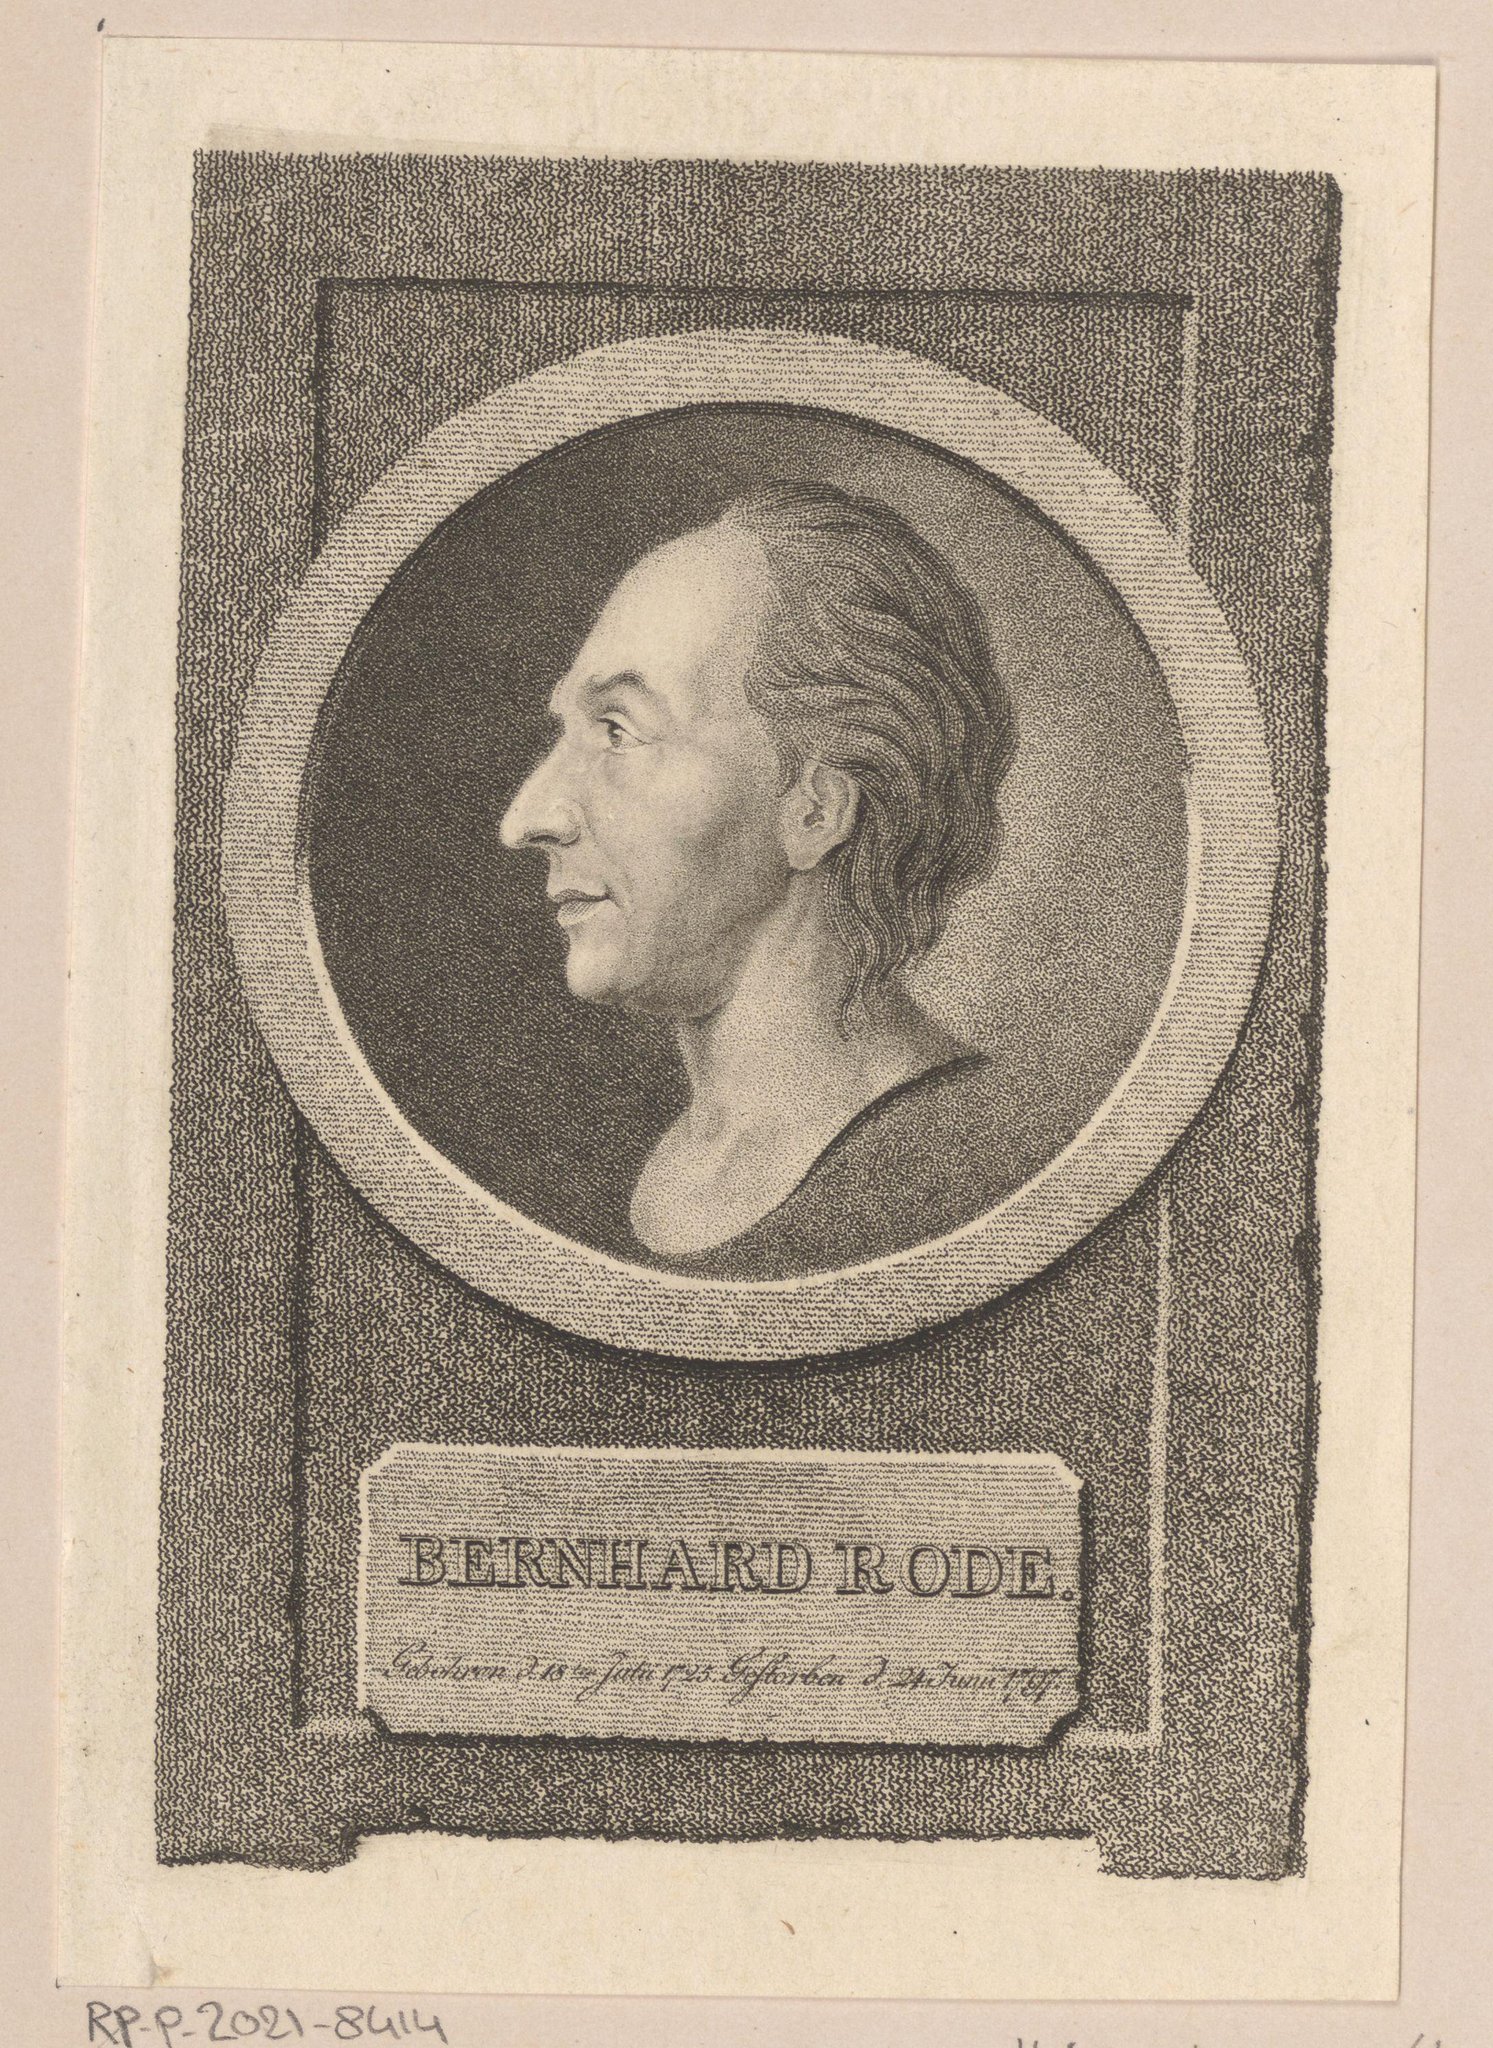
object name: print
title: Portret van Christian Bernhard Rode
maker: Anonymous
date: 1797-1849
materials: paper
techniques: engraving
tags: berlin, print maker, artist, bernhard rode, historical persons